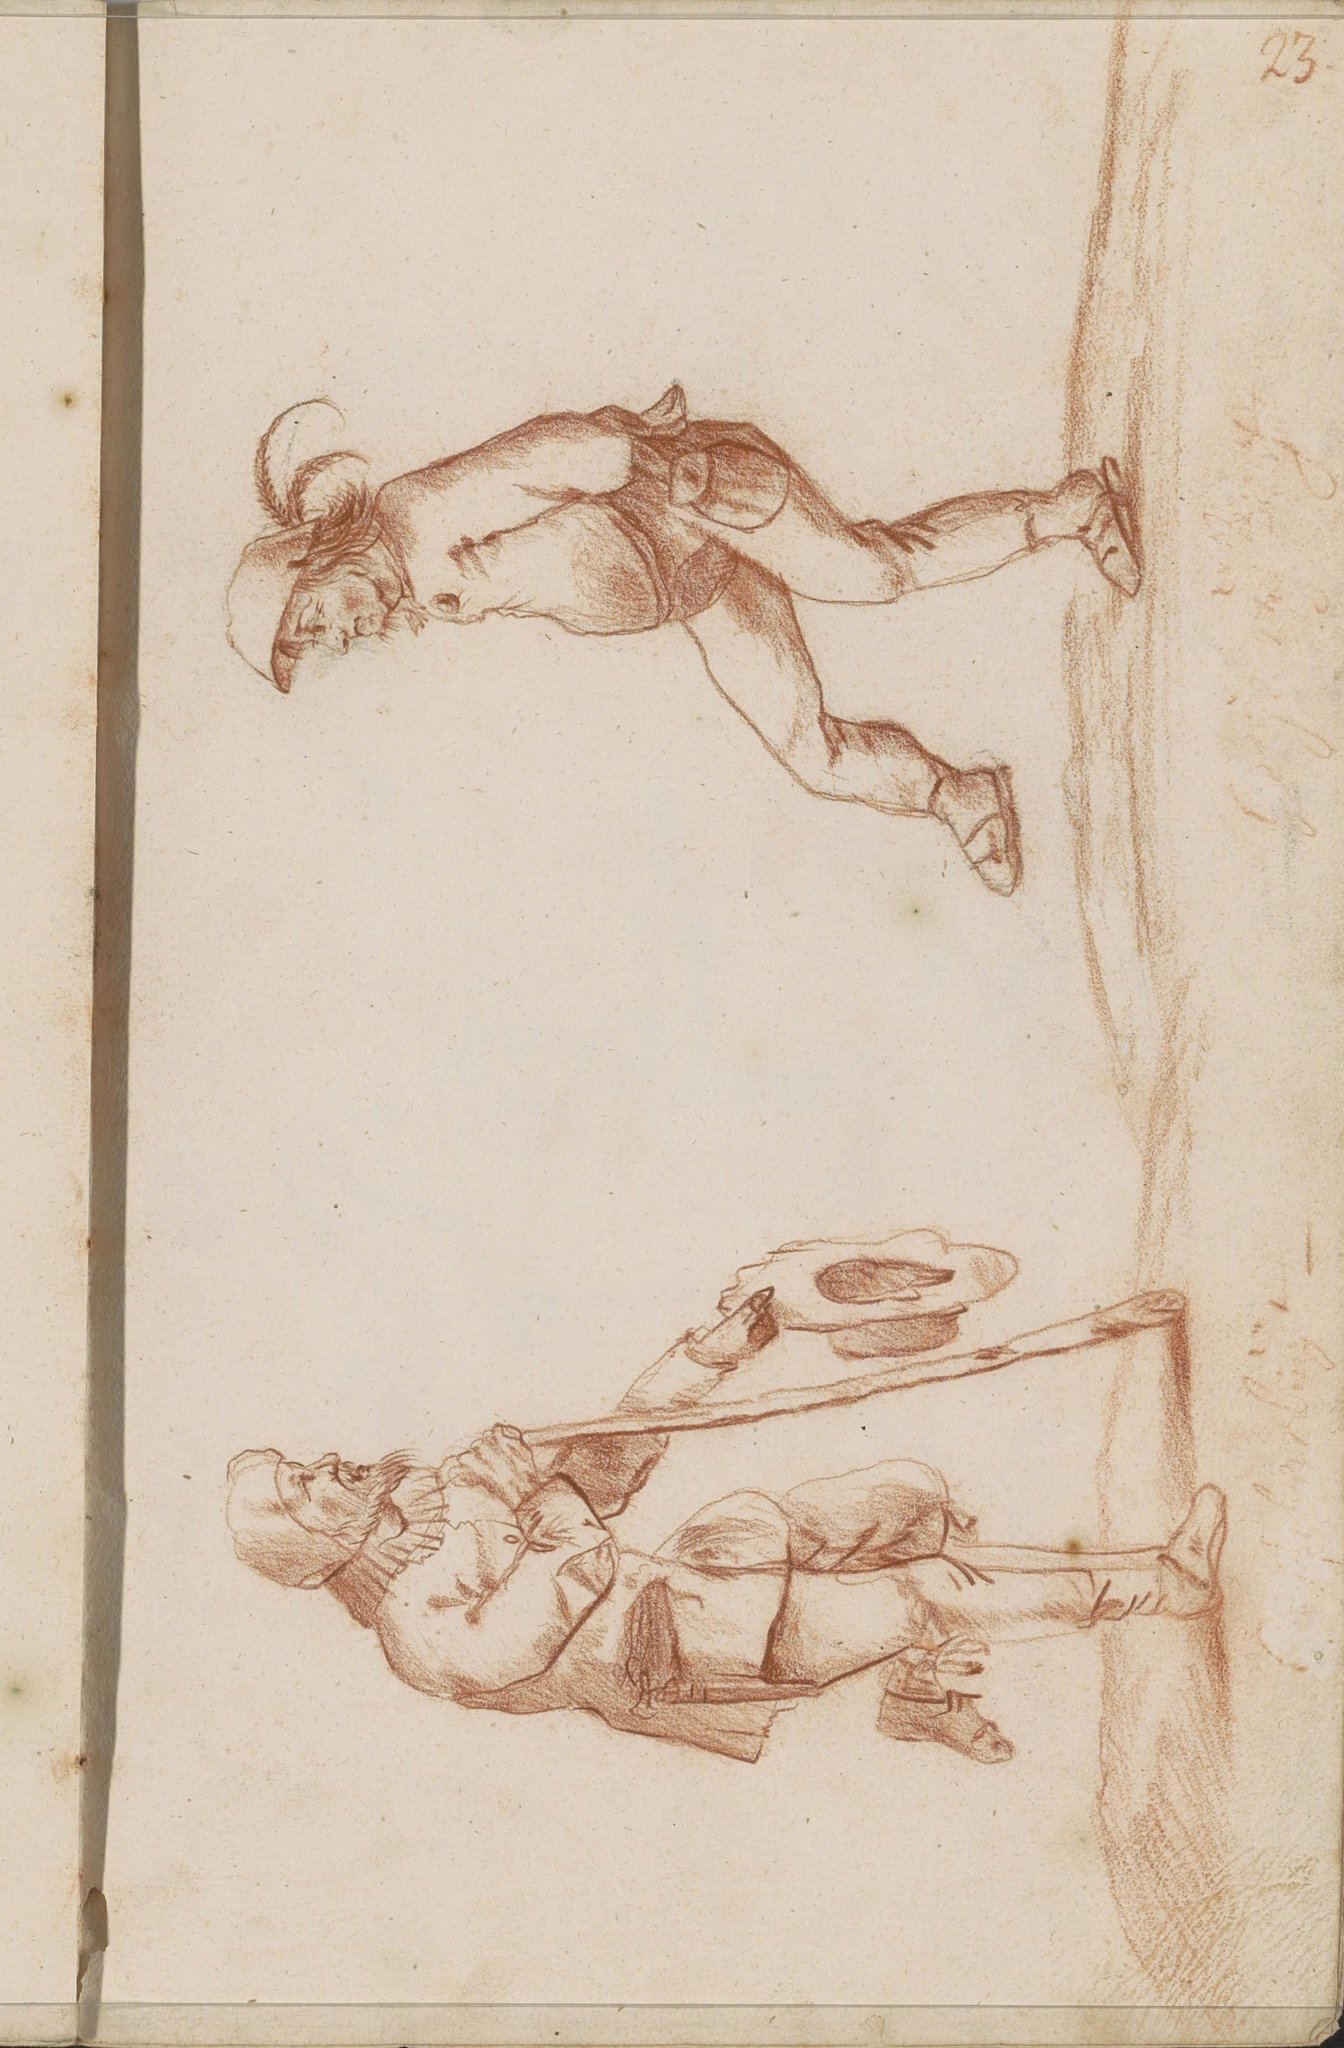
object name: sketchbook leaf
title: Man steunend op een stok en een man met de handen op de rug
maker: hendrick van beaumont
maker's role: draughtsman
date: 1696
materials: chalk, paper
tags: walking-stick, staff, person with a physical disability, man dancing alone, 'en route', traveller under way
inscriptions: number: ‘23’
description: De man houdt een hoed in de hand en leunt op een stok en een kniekruk. De andere man lijkt een dansbeweging te maken. Beide figuren staan in een landschap. Blad 18 recto uit een schetsboek met 30 bladen.